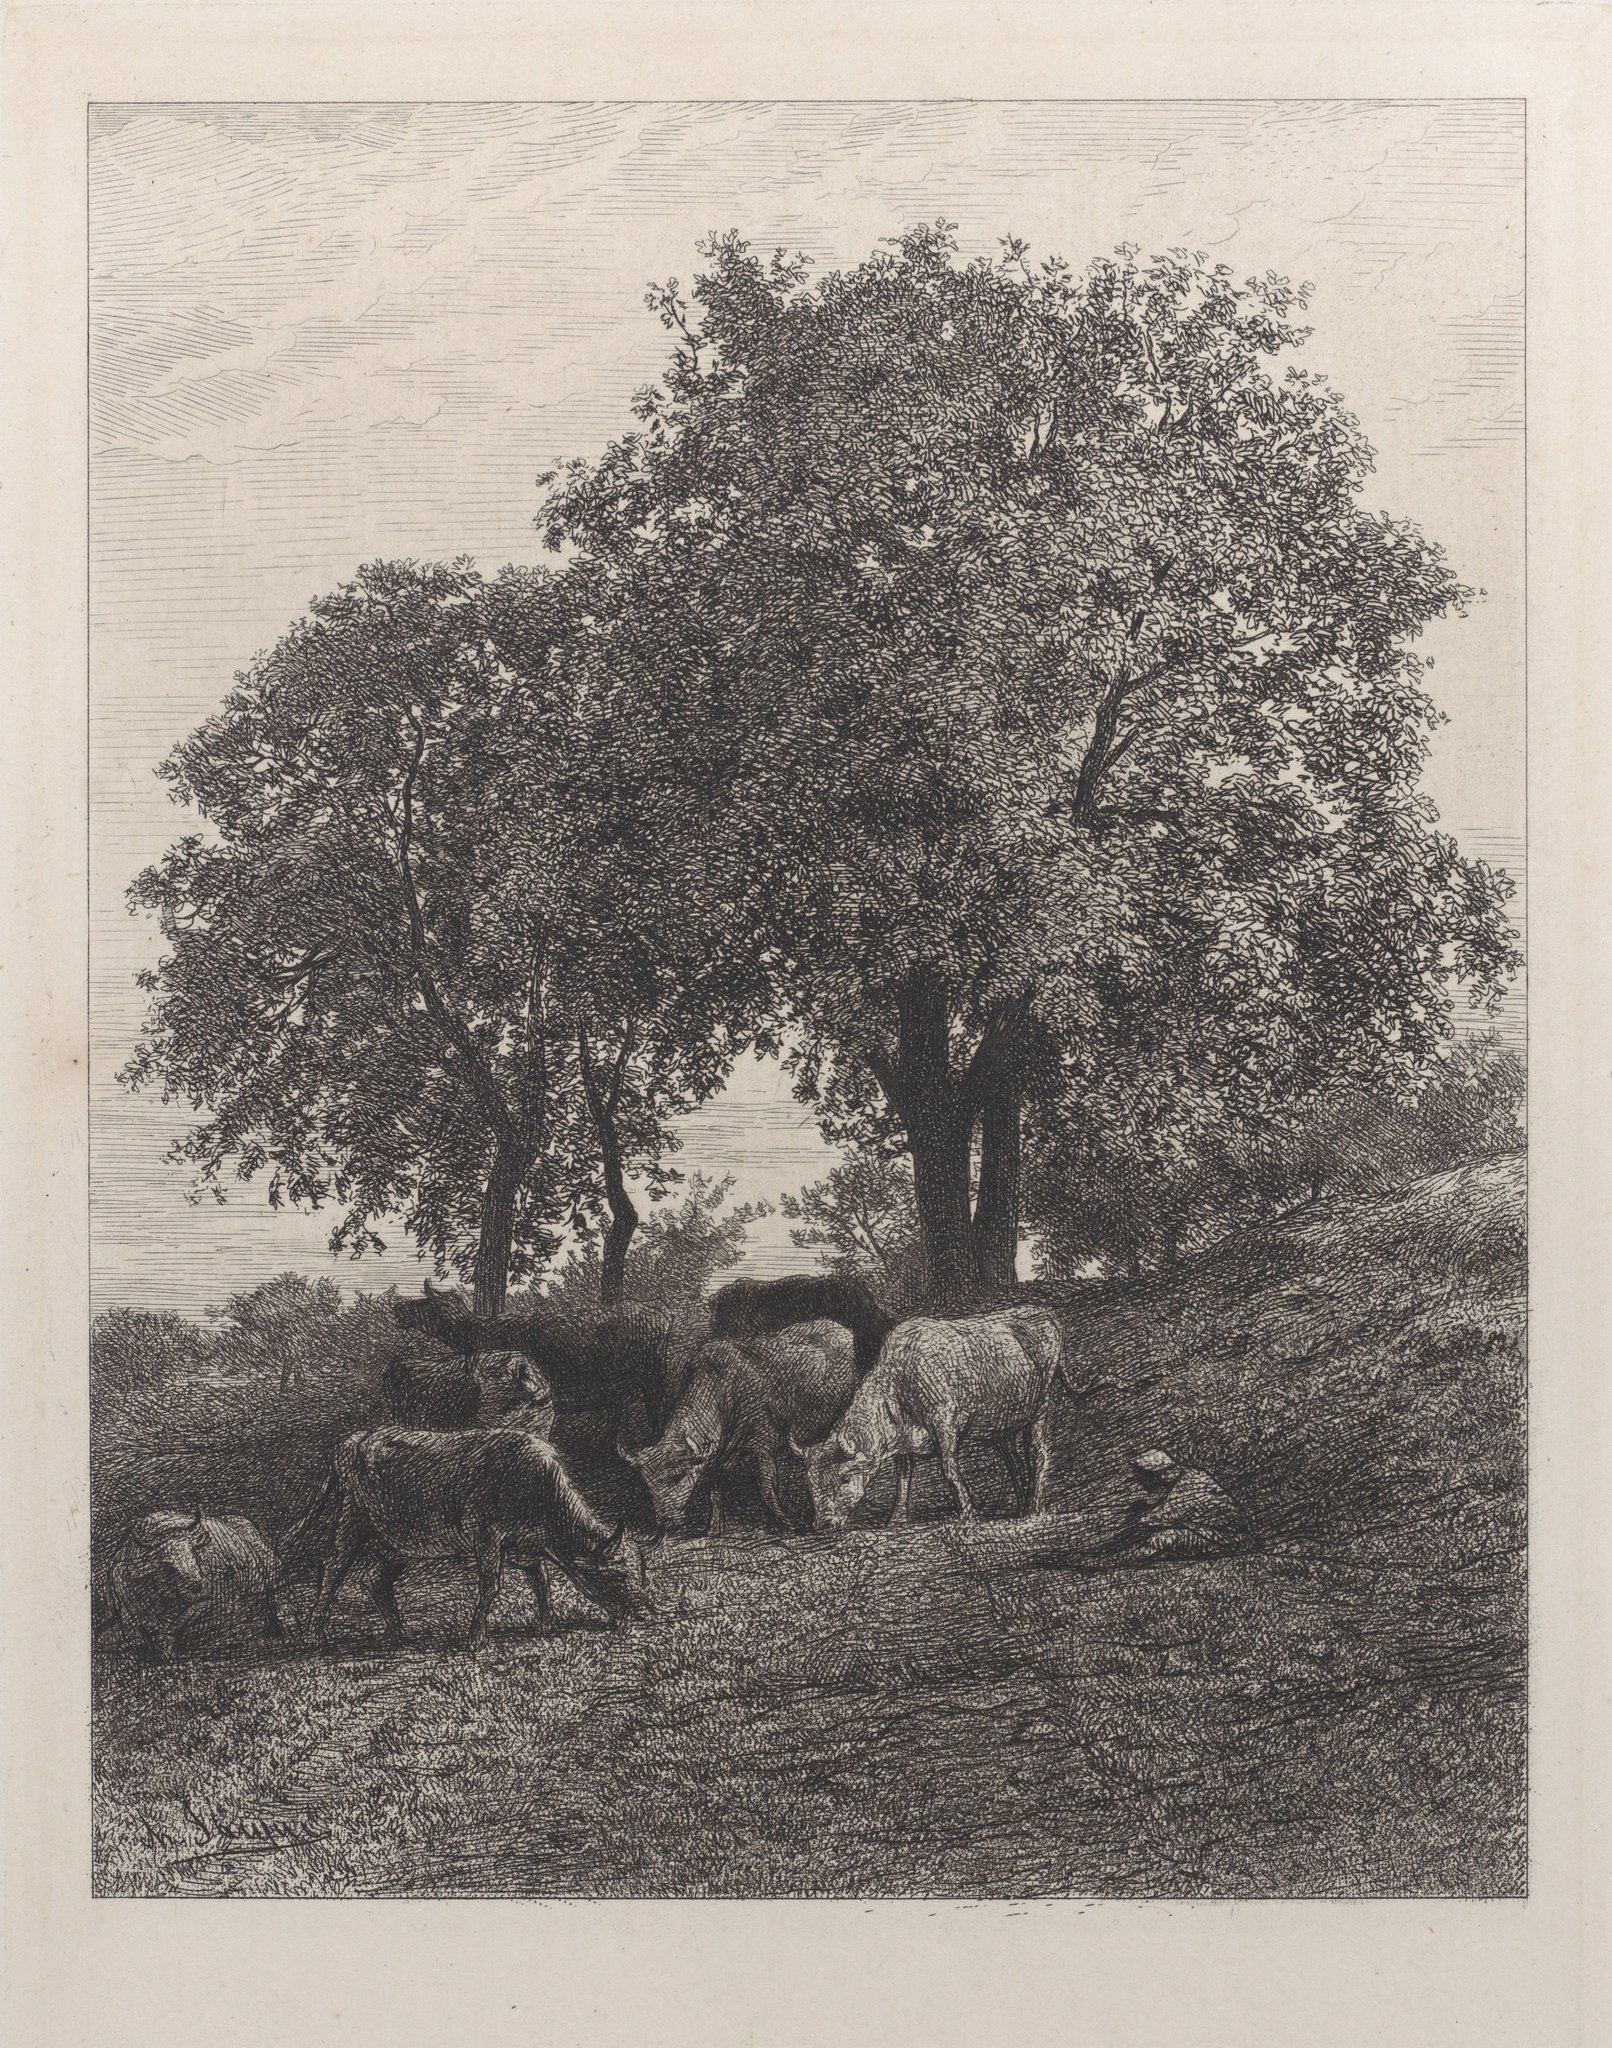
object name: print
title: Rest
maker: charles émile jacque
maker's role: artist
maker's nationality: french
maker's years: 1813-1894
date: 1864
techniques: etching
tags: cows,trees